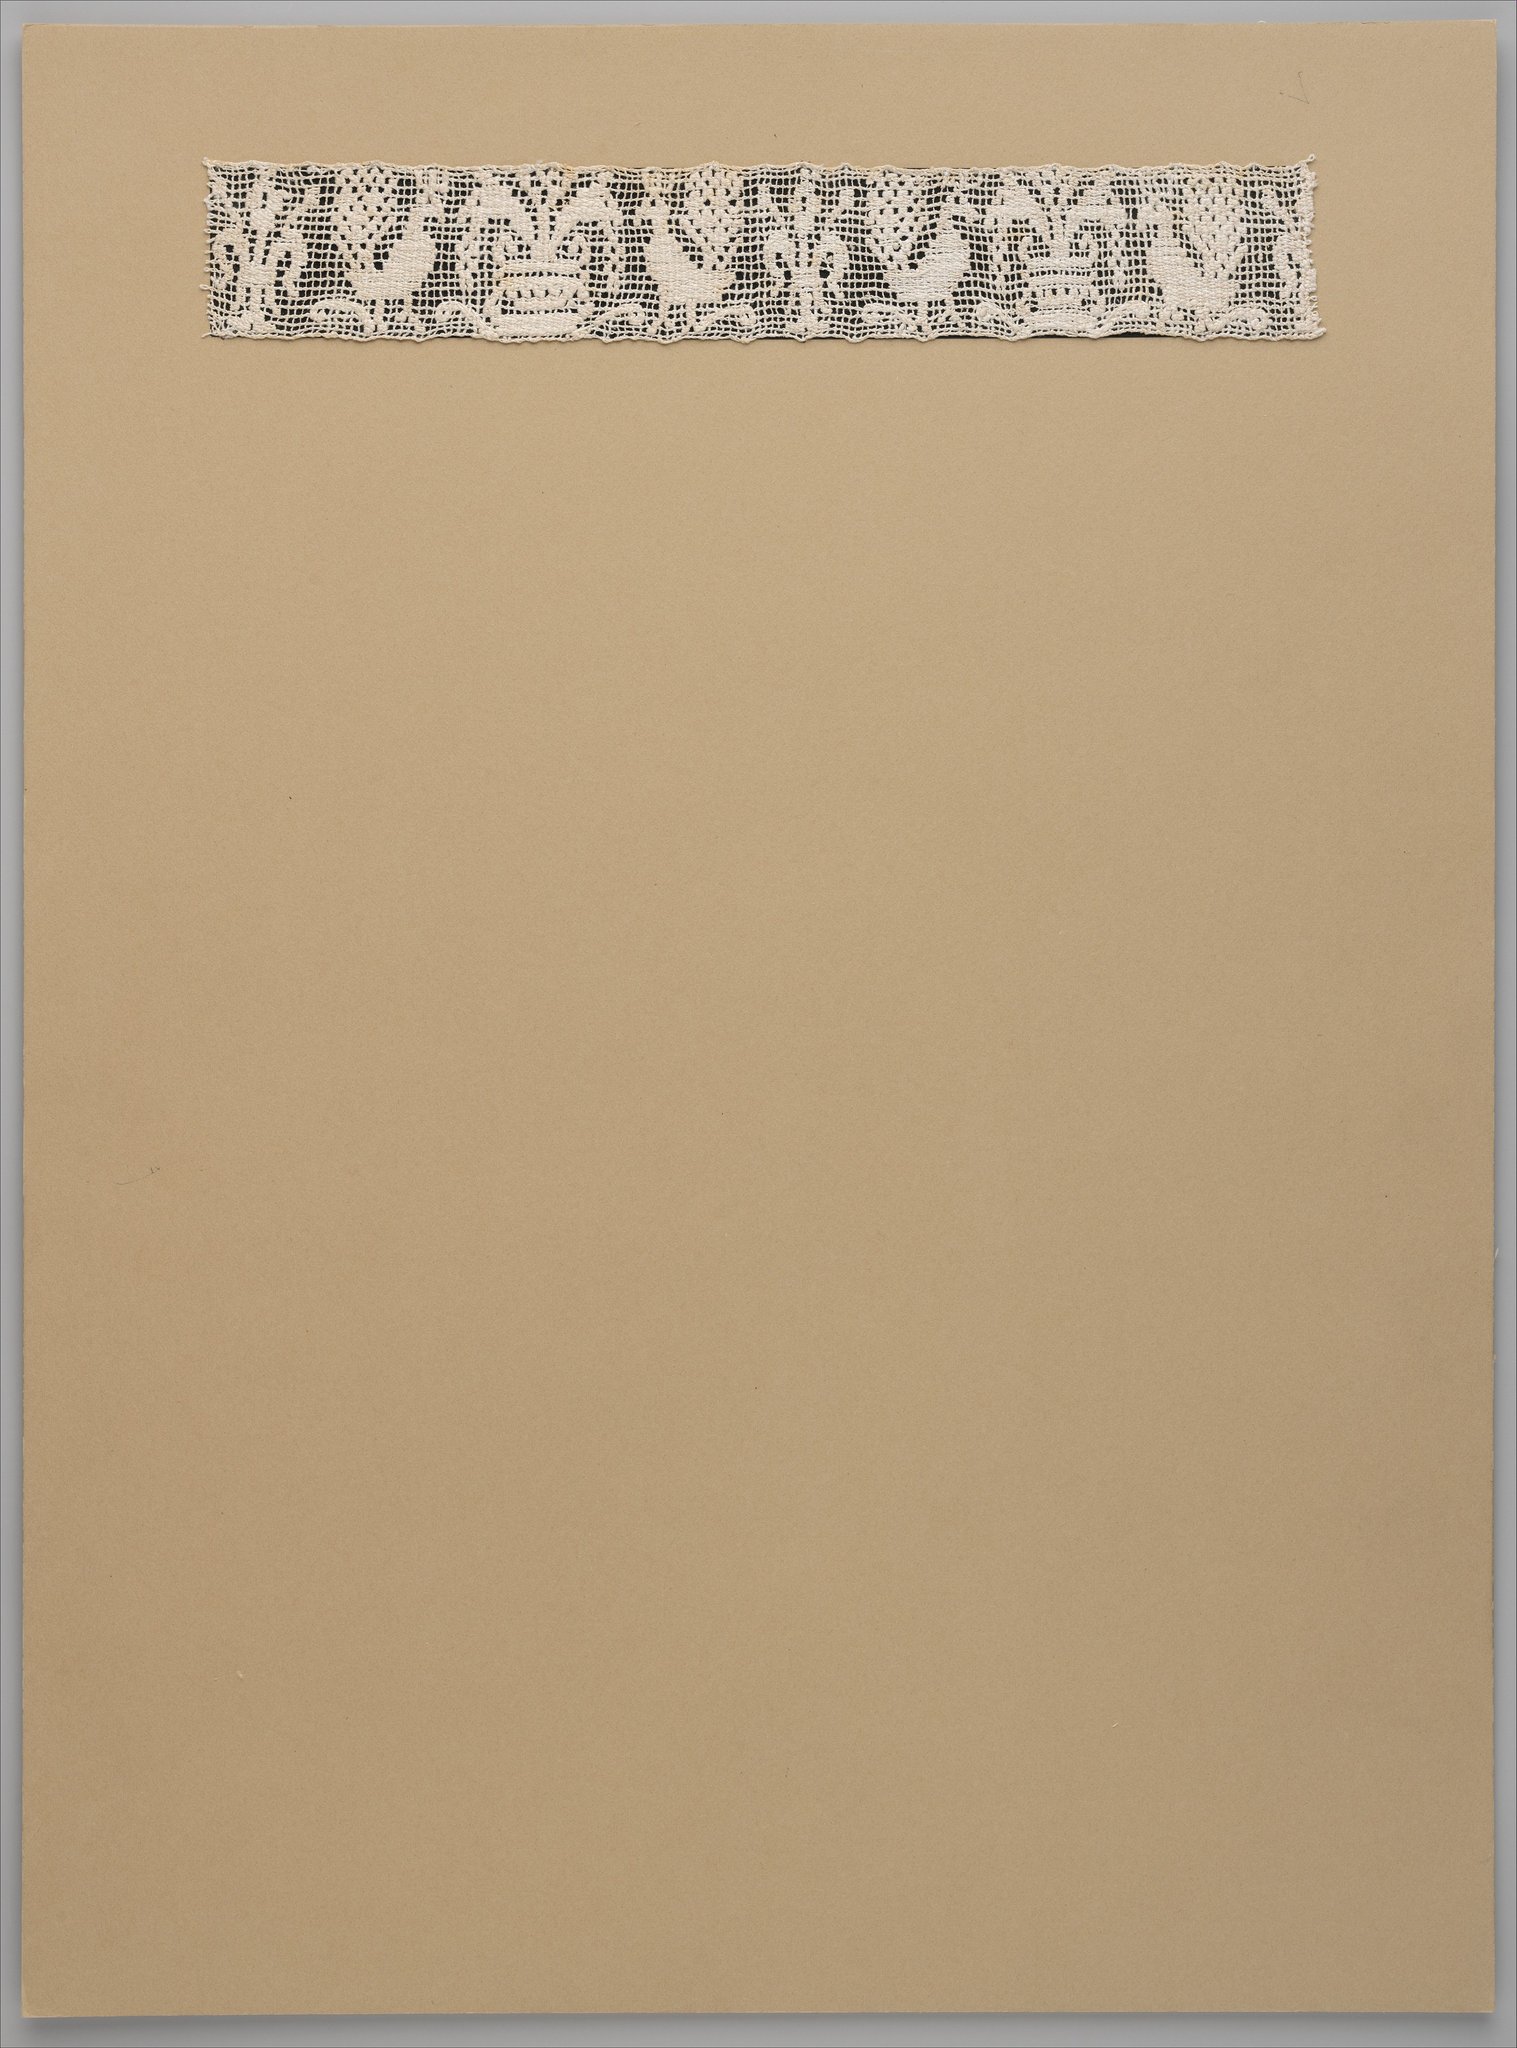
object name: band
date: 1501-1600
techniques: lace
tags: birds